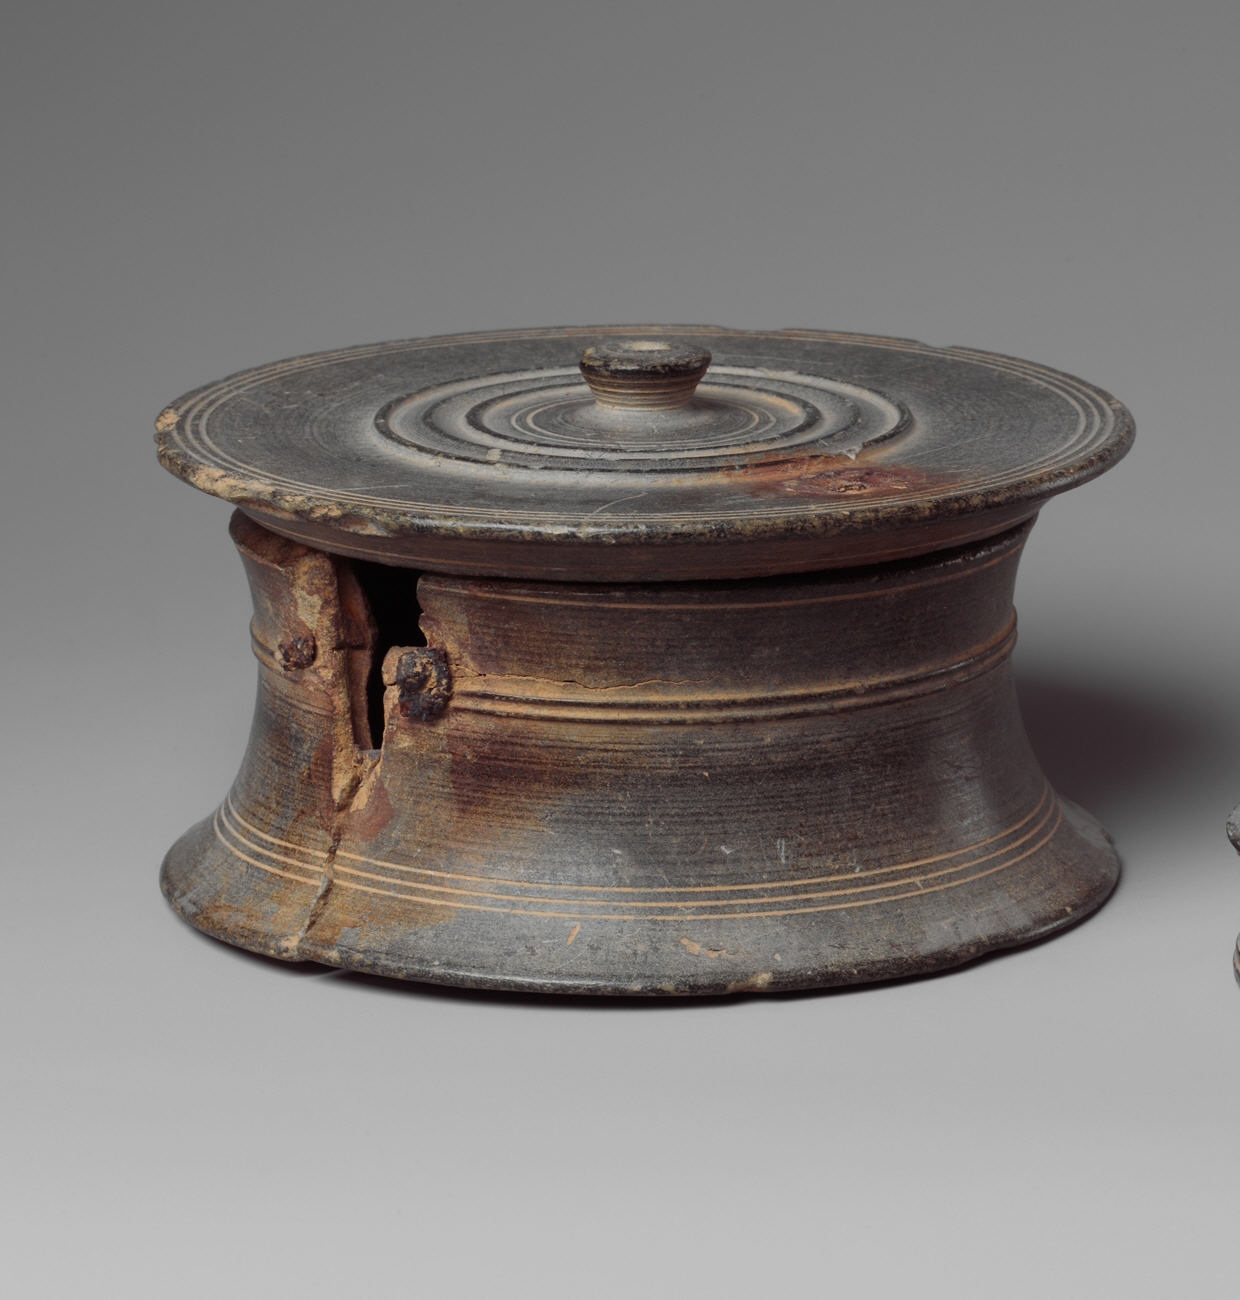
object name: reliquary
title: Reliquary with Ancient Repairs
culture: gandhara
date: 1-100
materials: stone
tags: gandhara